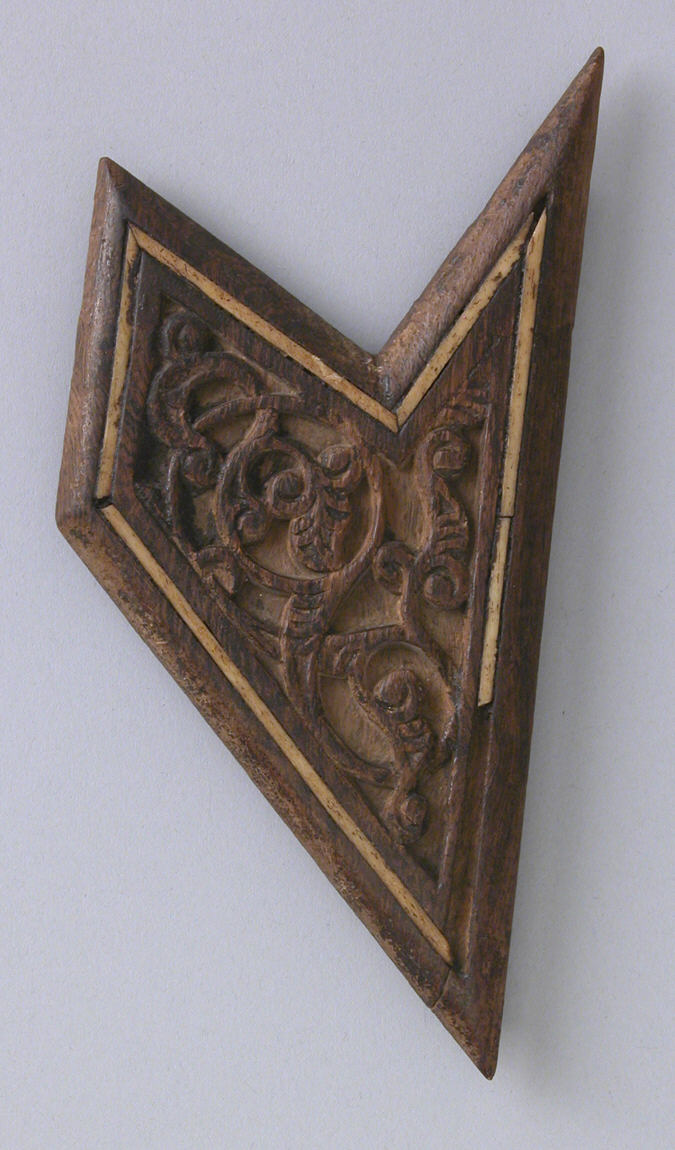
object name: panel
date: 1301-1500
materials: ivory, wood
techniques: carving, inlay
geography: egypt